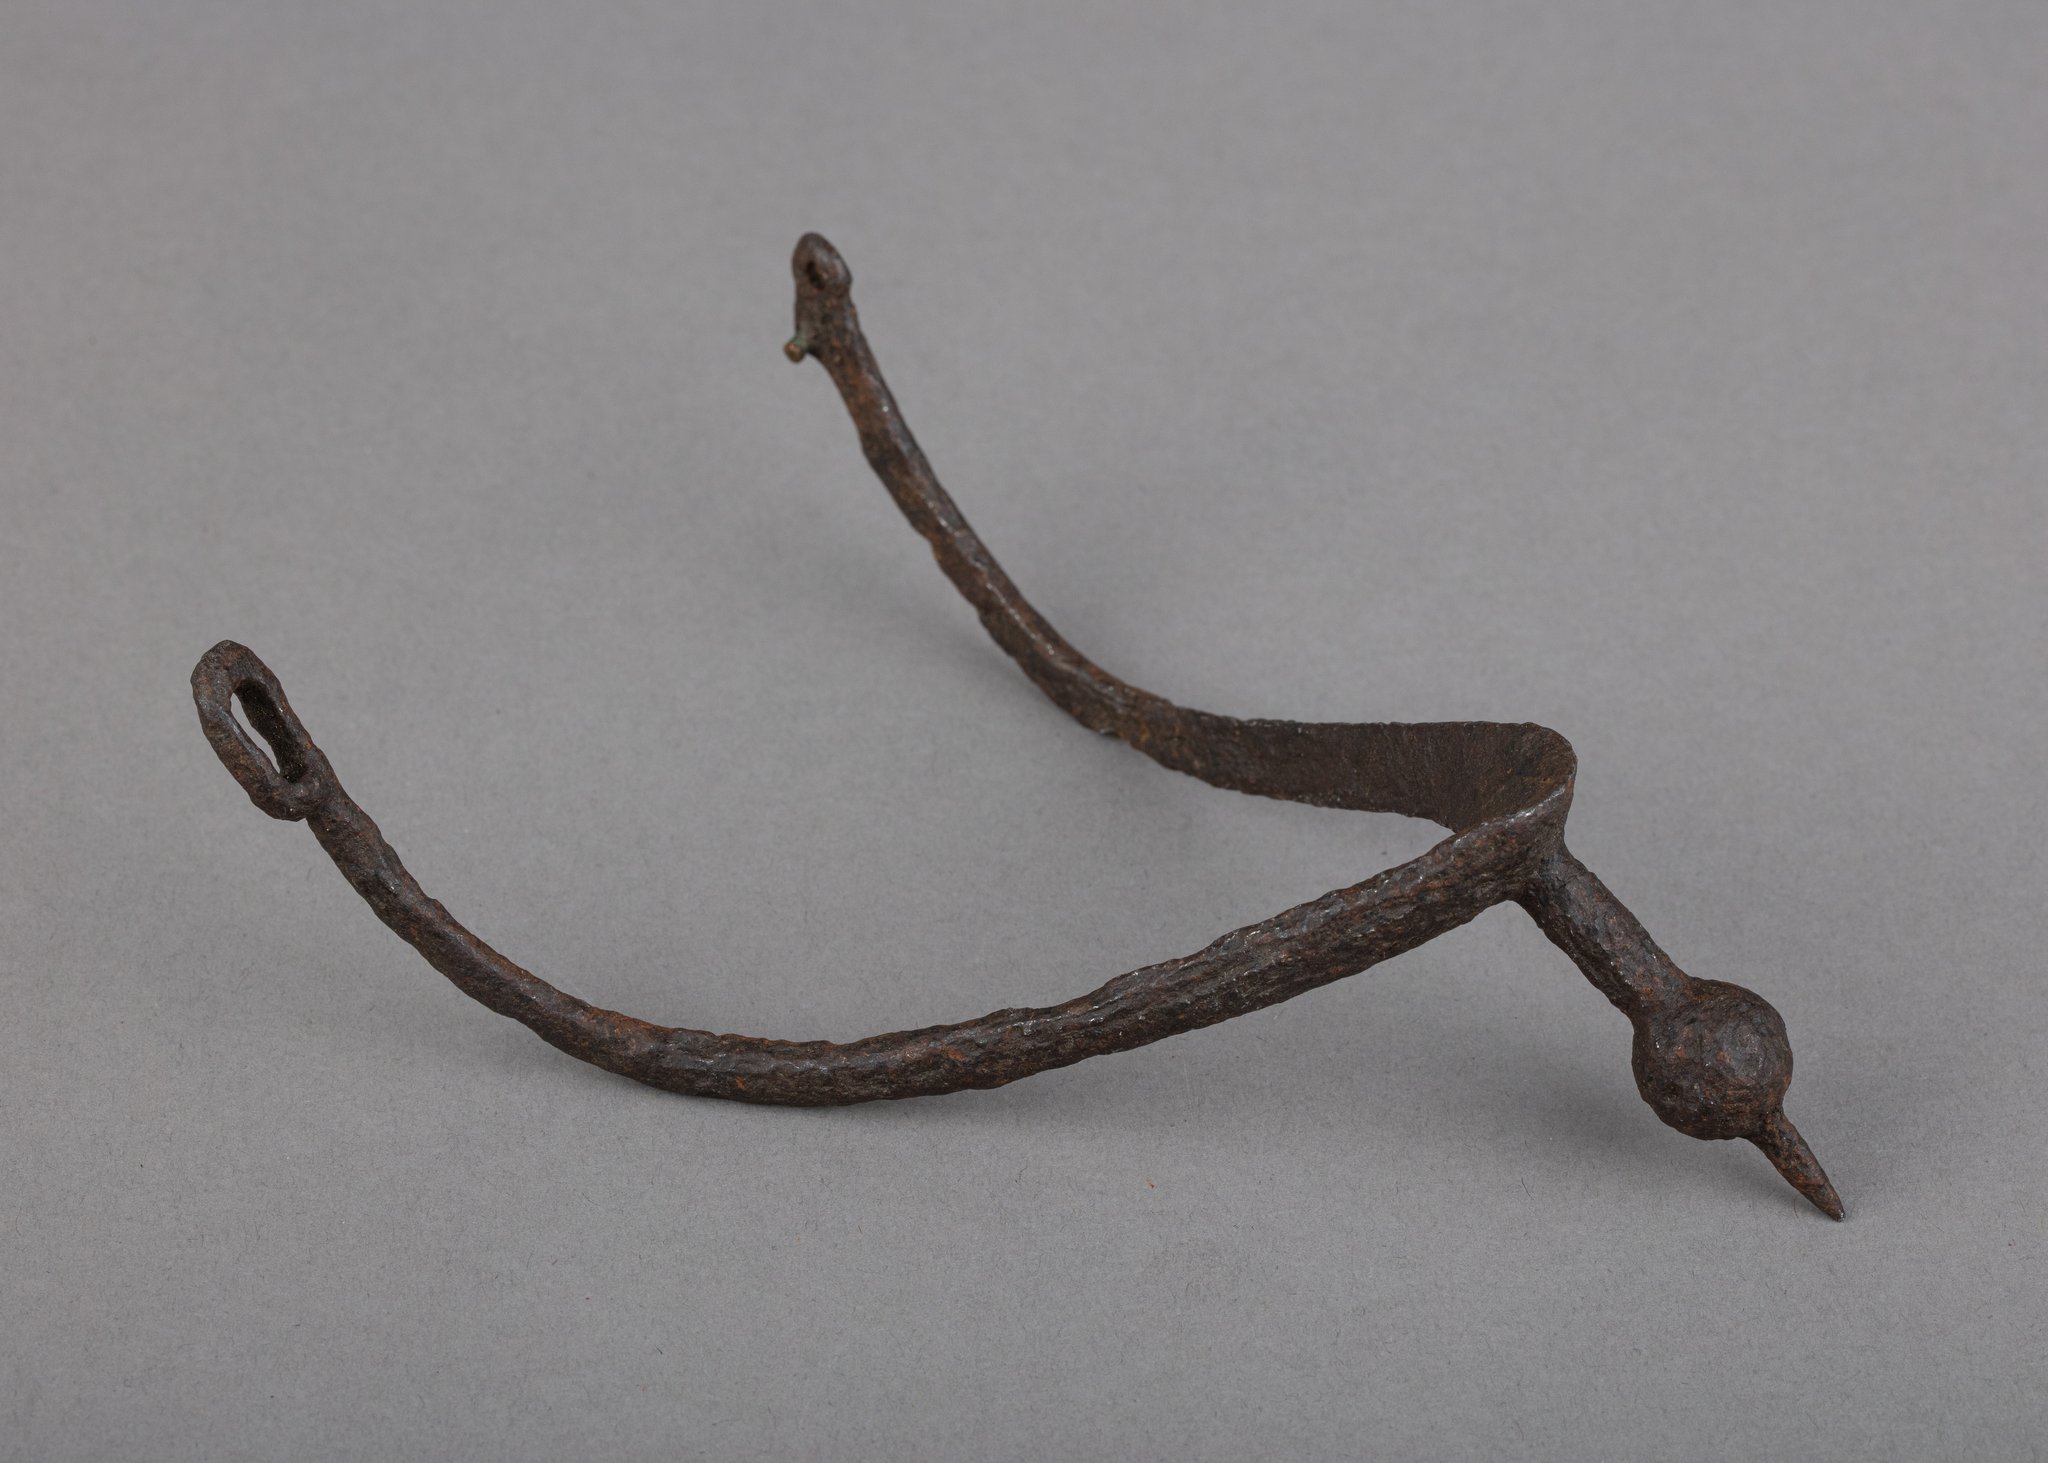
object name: spur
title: Prick Spur (Left)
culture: italian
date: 1201-1300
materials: copper alloy, metal alloy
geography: italy